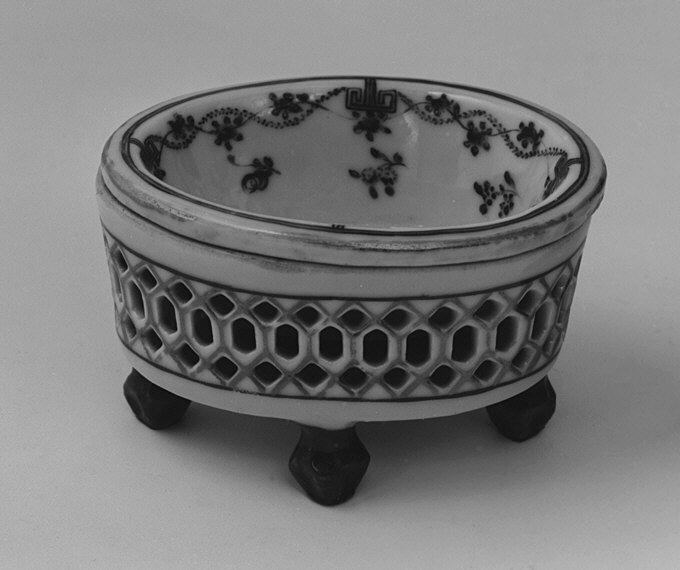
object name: salt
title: Salt (part of a service)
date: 1790-1800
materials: hard paste porcelain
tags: flowers